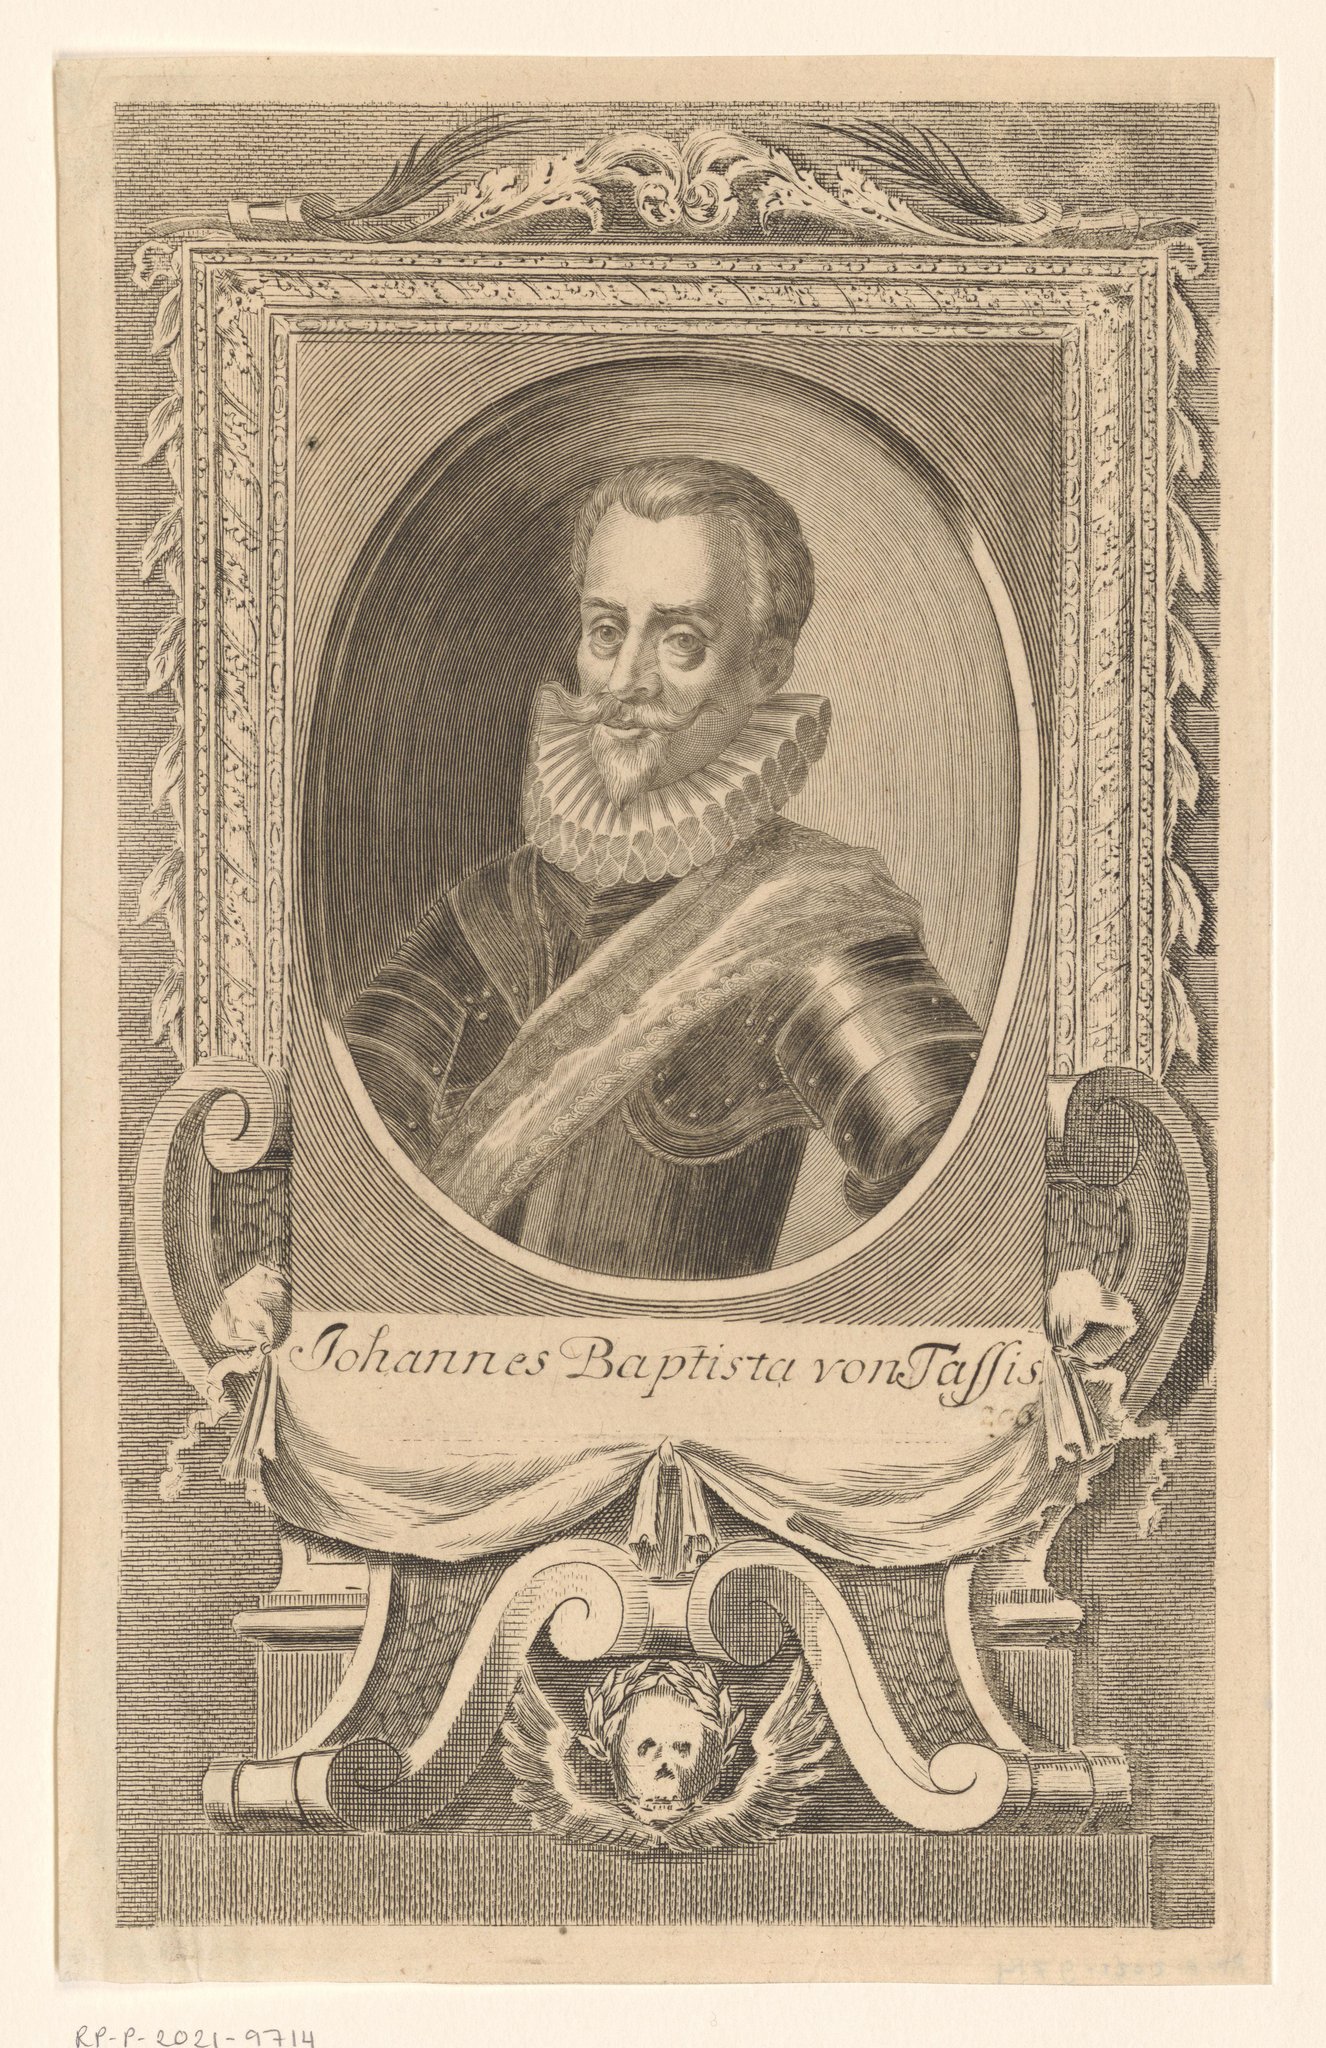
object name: print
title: Portret van Johann Baptista von Tassis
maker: Anonymous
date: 1700-1749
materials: paper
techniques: engraving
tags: armour, historical persons, officer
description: Prent mogelijk uit: Khevenhüller, Franz Christoph. Conterfet Kuperstich (...). Leipzig: Moritz Georg Weidmann, 1721-1722.